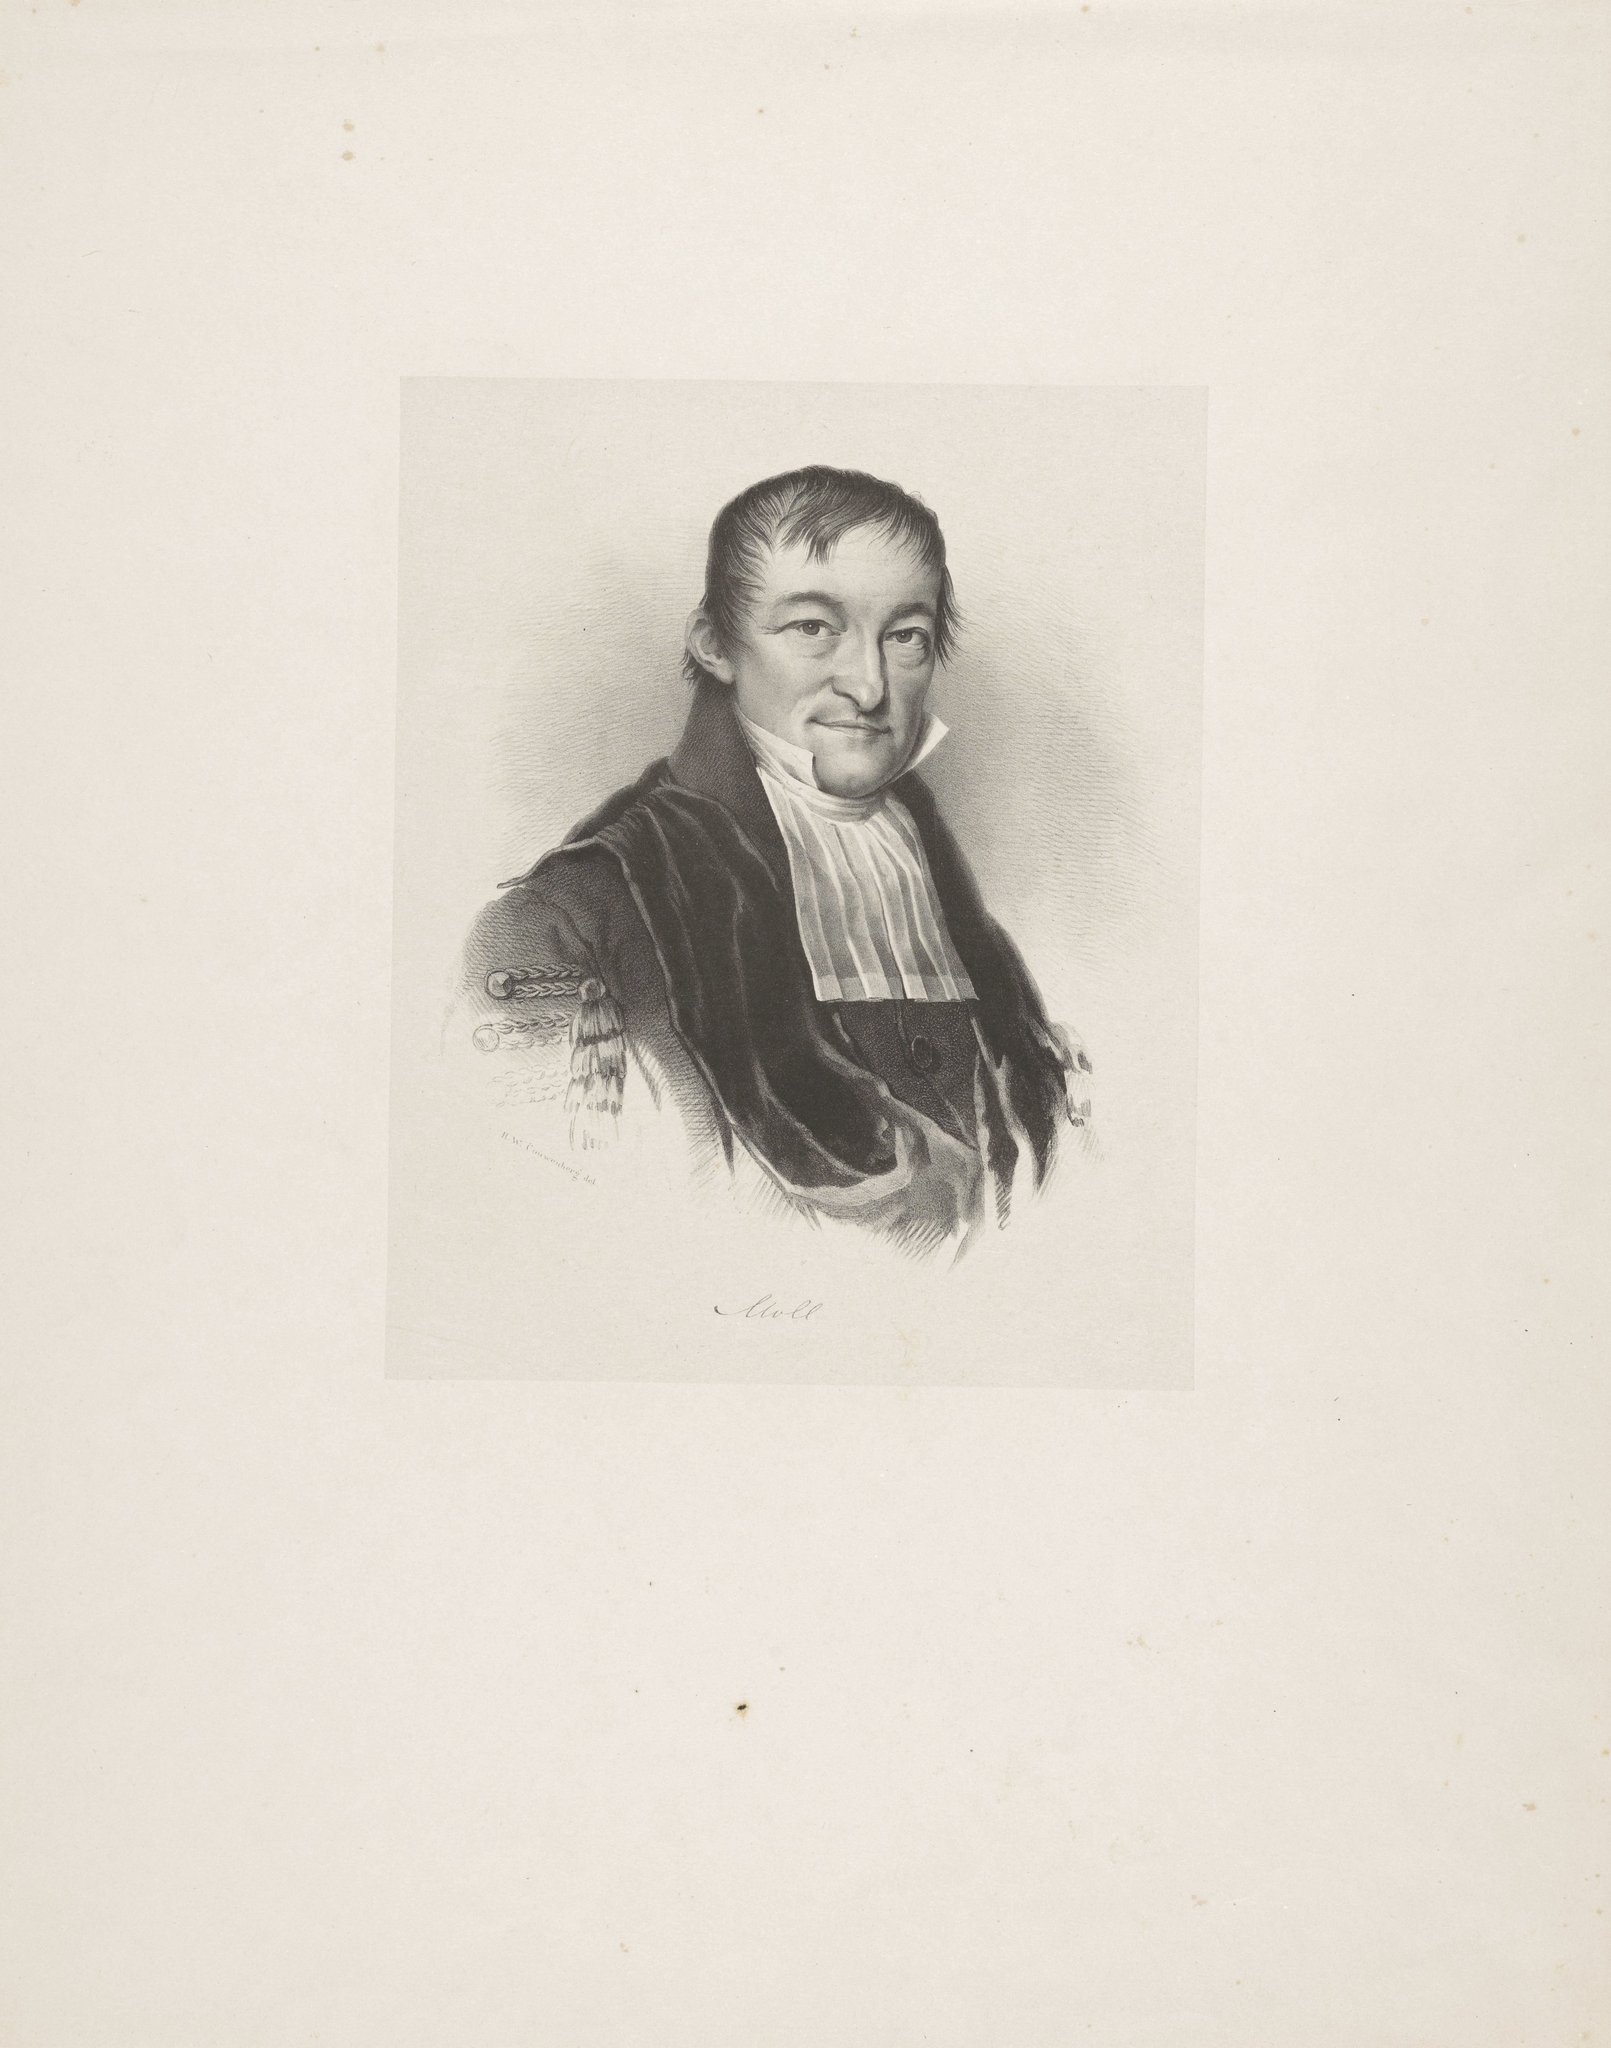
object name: print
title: Portret van Gerrit Moll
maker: henricus wilhelmus couwenberg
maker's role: draughtsman, print maker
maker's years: 1814-1845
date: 1838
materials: paper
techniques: lithograph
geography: amsterdam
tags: professor, historical persons (+ (full) bust portrait)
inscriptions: collector's mark: Lugt 2228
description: De geportretteerde draagt een toga en een witte bef met opstaande witte kraag.